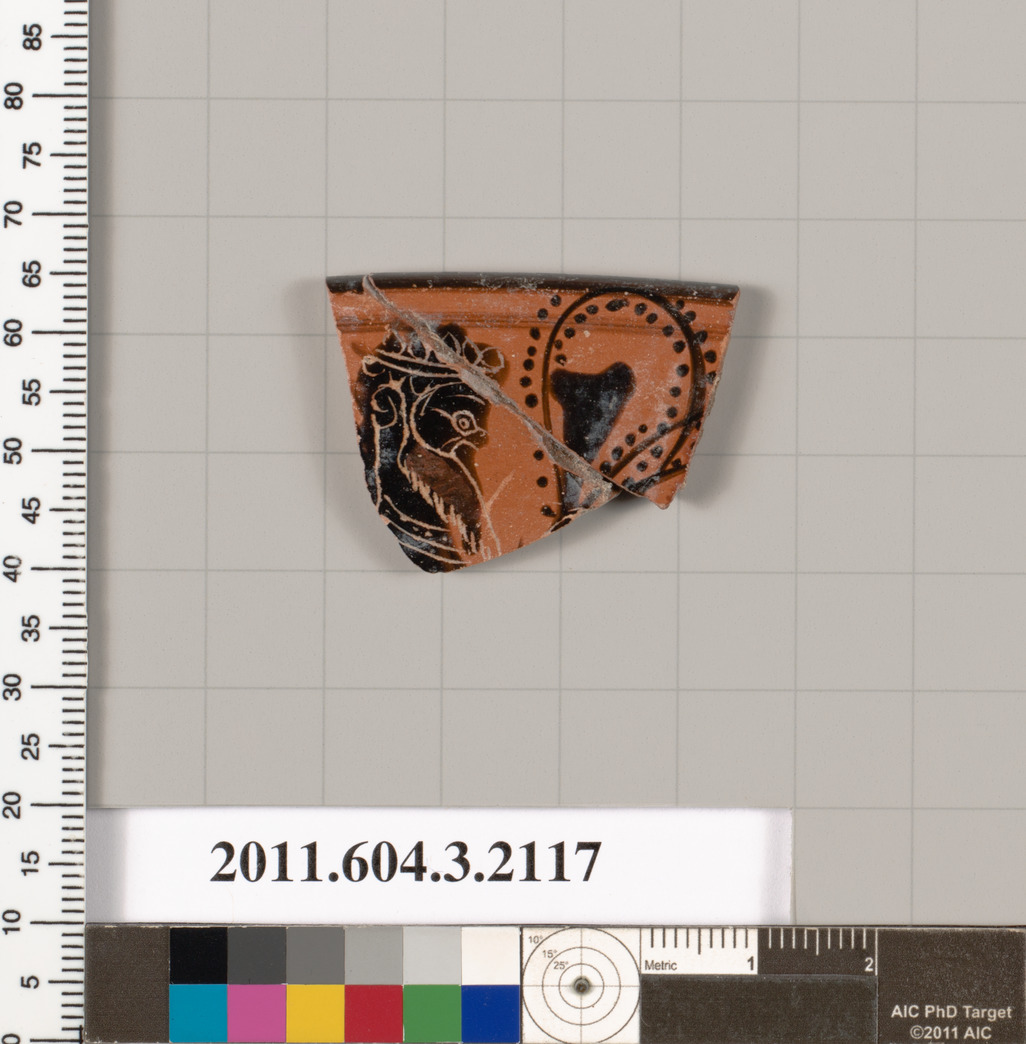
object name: kylix fragment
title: Terracotta rim fragment of a kylix (drinking cup)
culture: greek, attic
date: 525-501 BCE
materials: terracotta